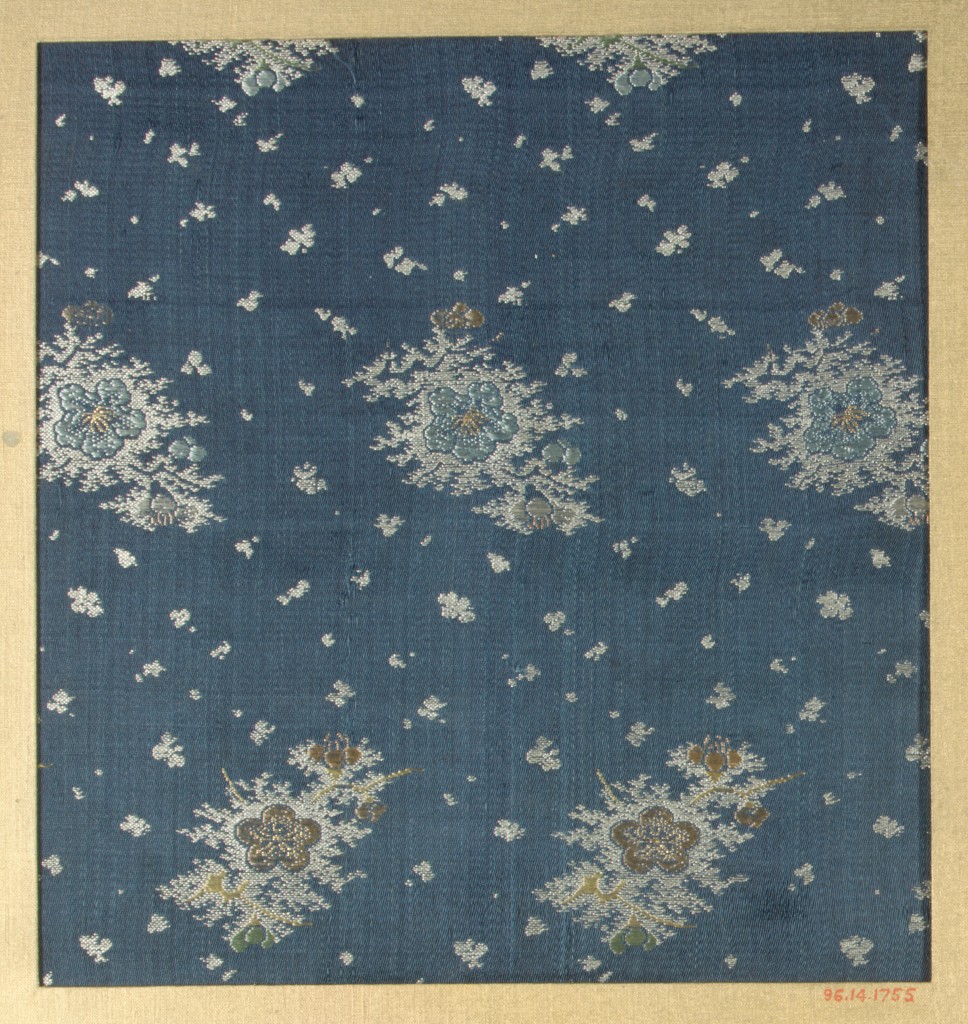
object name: piece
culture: japanese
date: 1701-1900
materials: silk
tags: flowers